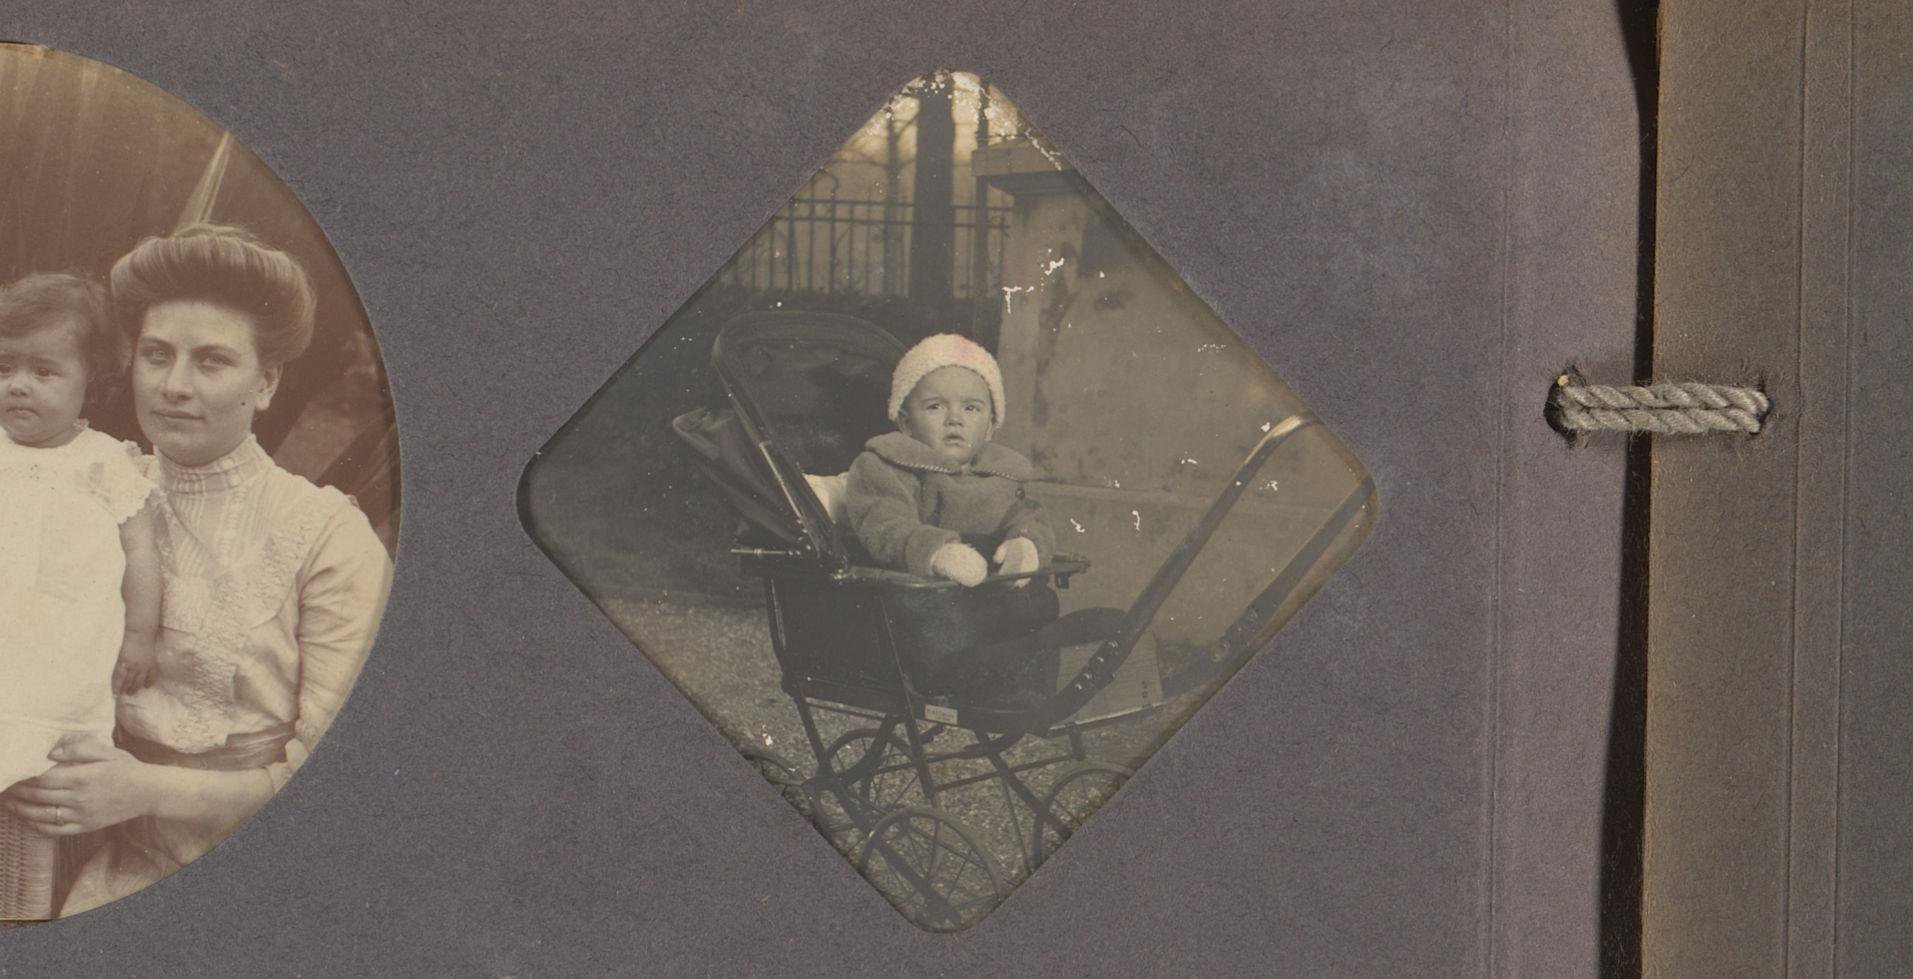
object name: photograph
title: Kind in een kinderwagen, aangeduid als Guus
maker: Anonymous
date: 1908-1912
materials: paper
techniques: gelatin silver print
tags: baby-carriage, pram, perambulator, toddler